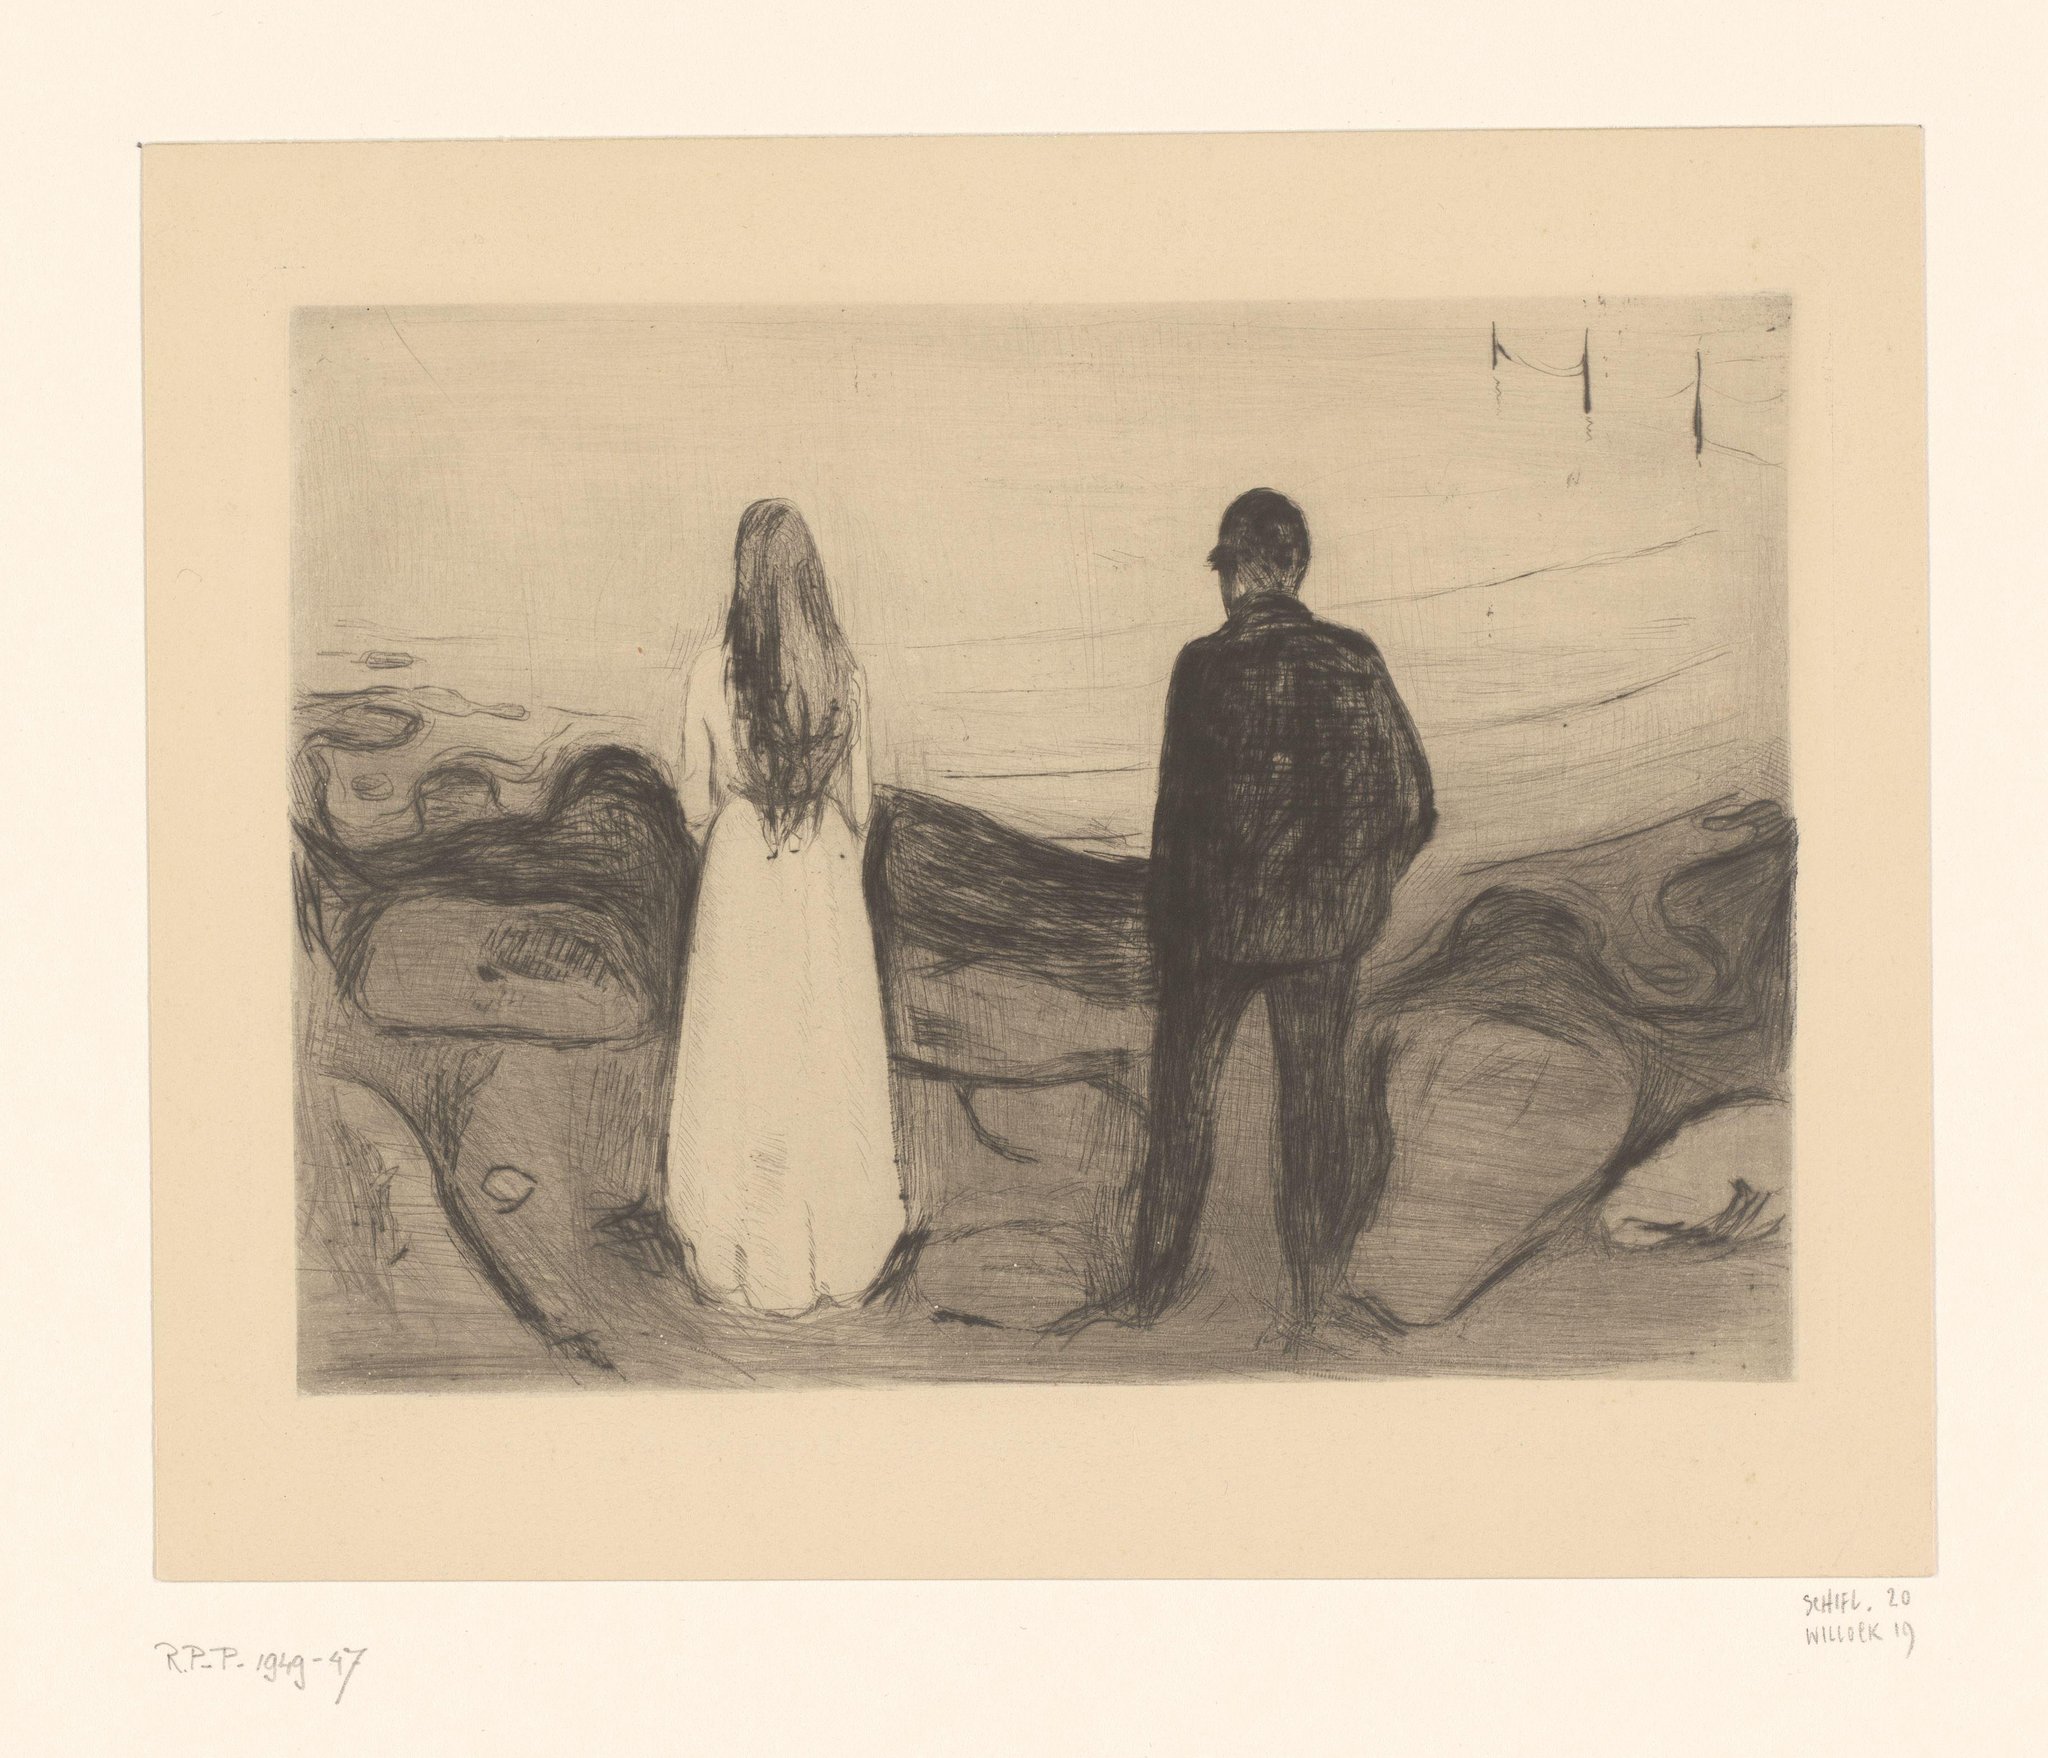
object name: print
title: Man en vrouw staand aan de oever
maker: edvard munch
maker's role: print maker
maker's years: 1863-1944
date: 1894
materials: paper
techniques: drypoint, intaglio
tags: standing figure, water course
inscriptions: collector's mark: Lugt 2228